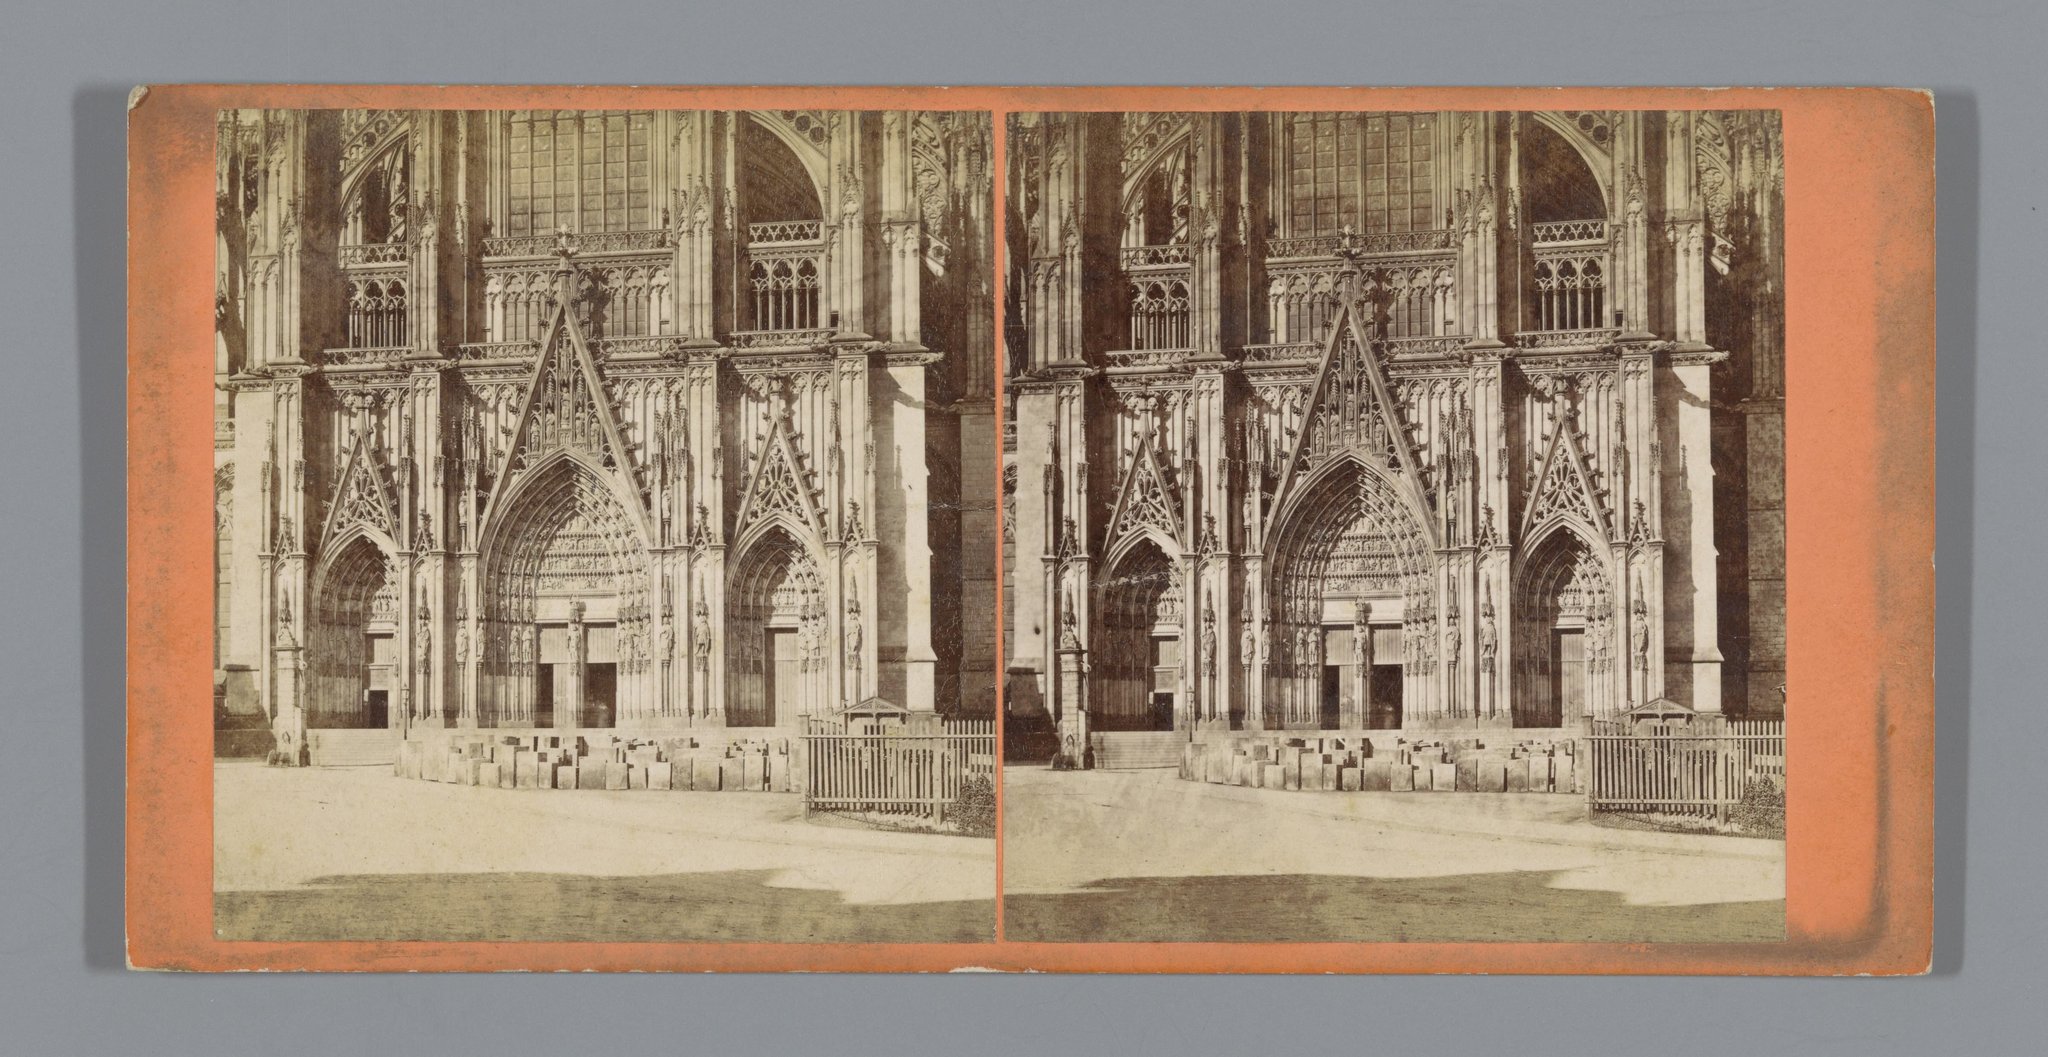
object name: stereograph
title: Zuidelijk toegangsportaal van de Dom van Keulen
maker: františek fridrich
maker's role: publisher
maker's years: 1829-1892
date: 1860-1880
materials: cardboard, photographic support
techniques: albumen print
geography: cologne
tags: parts of church exterior and annexes: portal, façade (of house or building)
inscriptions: number: ‘29.’